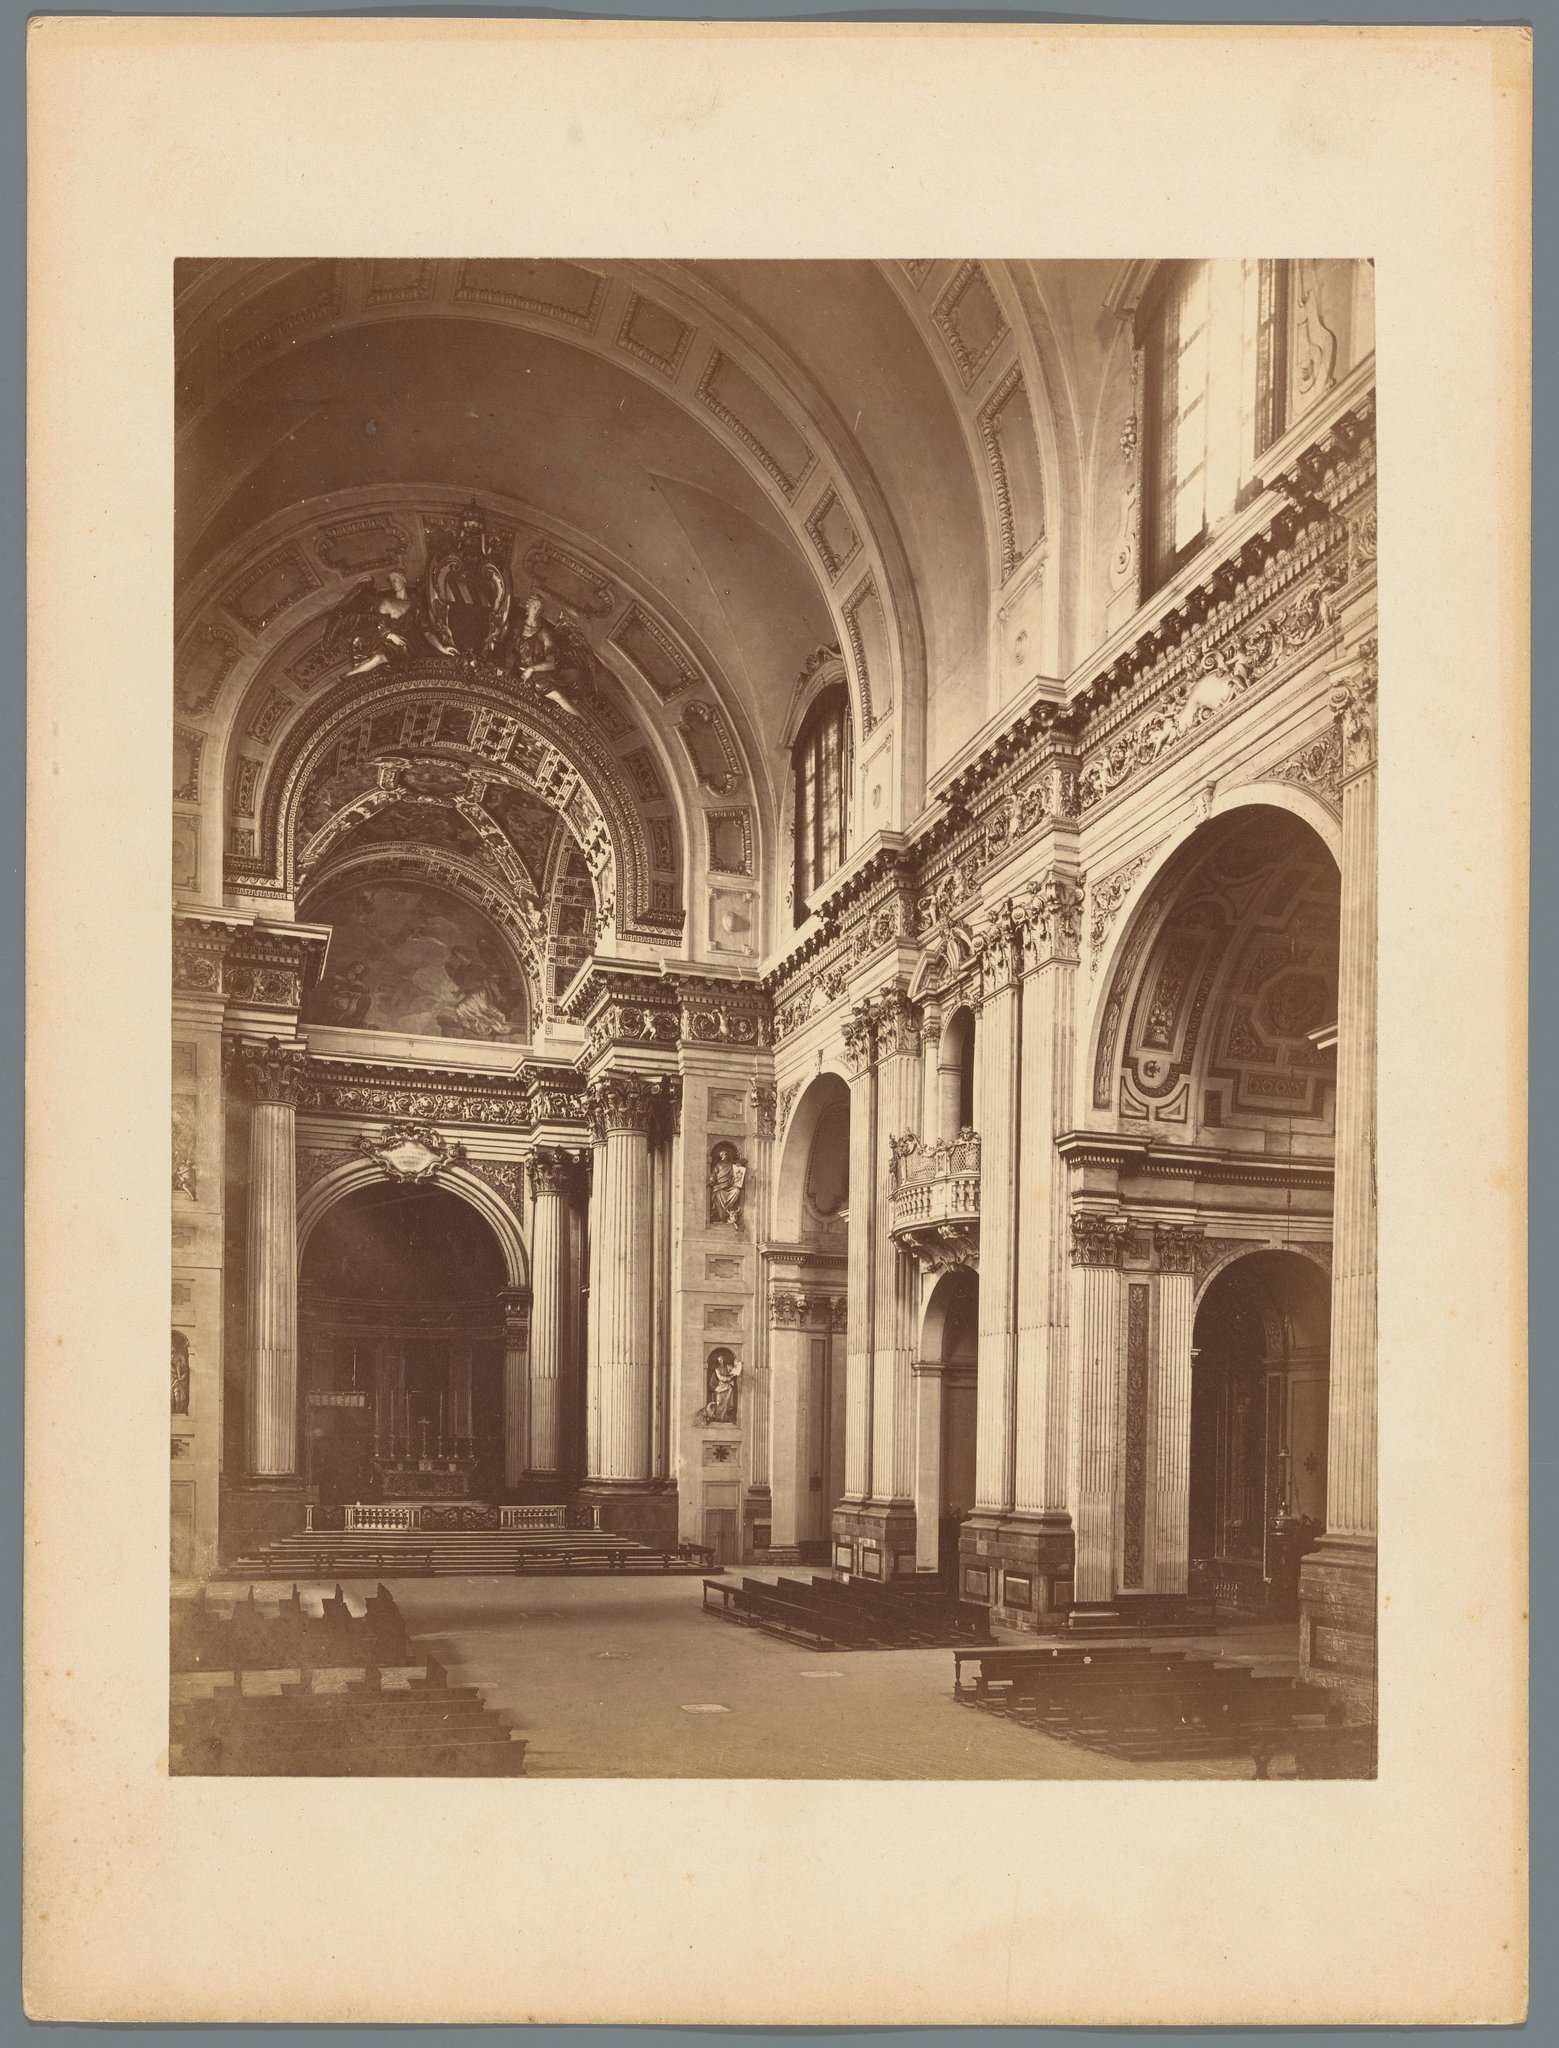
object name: photograph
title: Interieur van een kerk (vermoedelijk) in Italië, met zicht op het koor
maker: Anonymous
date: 1875-1900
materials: cardboard, photographic support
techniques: albumen print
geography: italy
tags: interior of church, parts of church interior: choir, italy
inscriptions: collector's mark: Lugt 3937